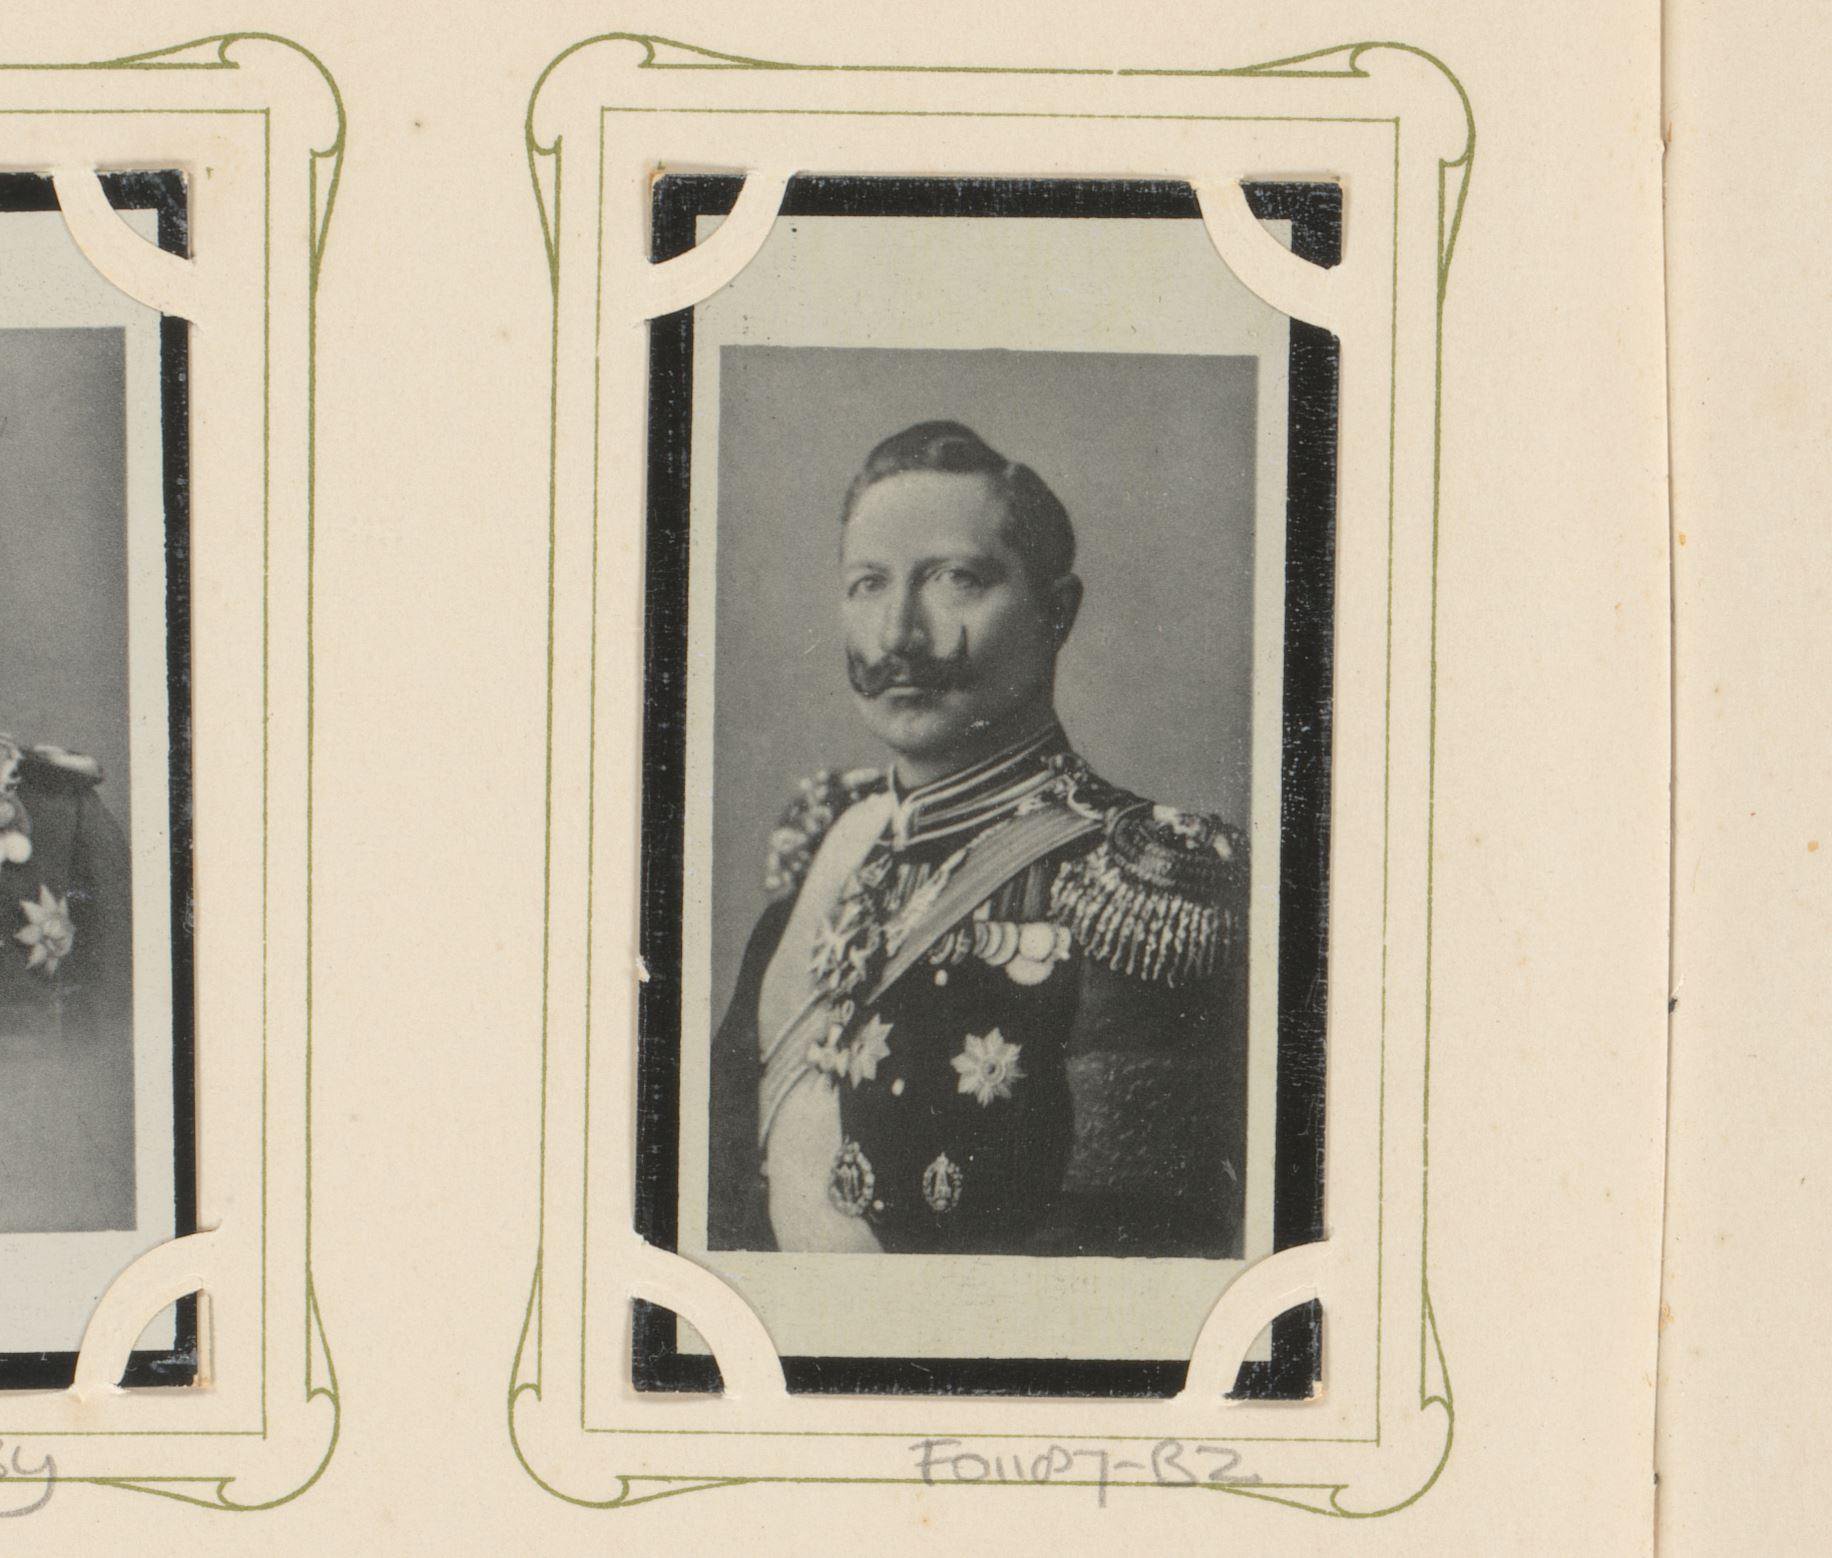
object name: photomechanical print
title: Portret van keizer Wilhelm II van Duitsland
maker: Anonymous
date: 1905-1906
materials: paper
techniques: photograph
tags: wilhelm ii (keizer van duitsland), historical persons, emperor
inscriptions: inscription: ‘No. 3./ Keizer Wilhelm van Duitschland.’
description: Deze prent maakt deel uit van een album.